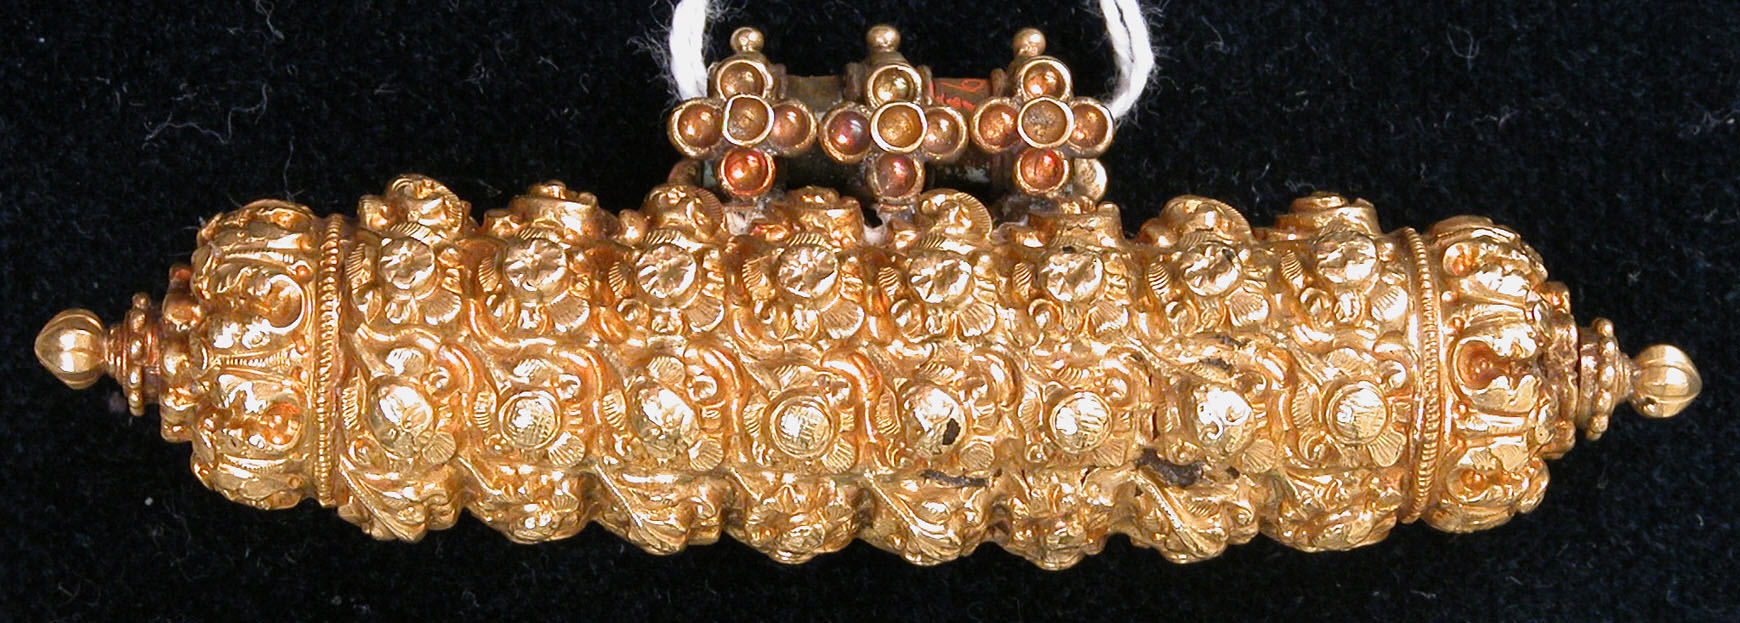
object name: amulet case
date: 1801-1900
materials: gold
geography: india